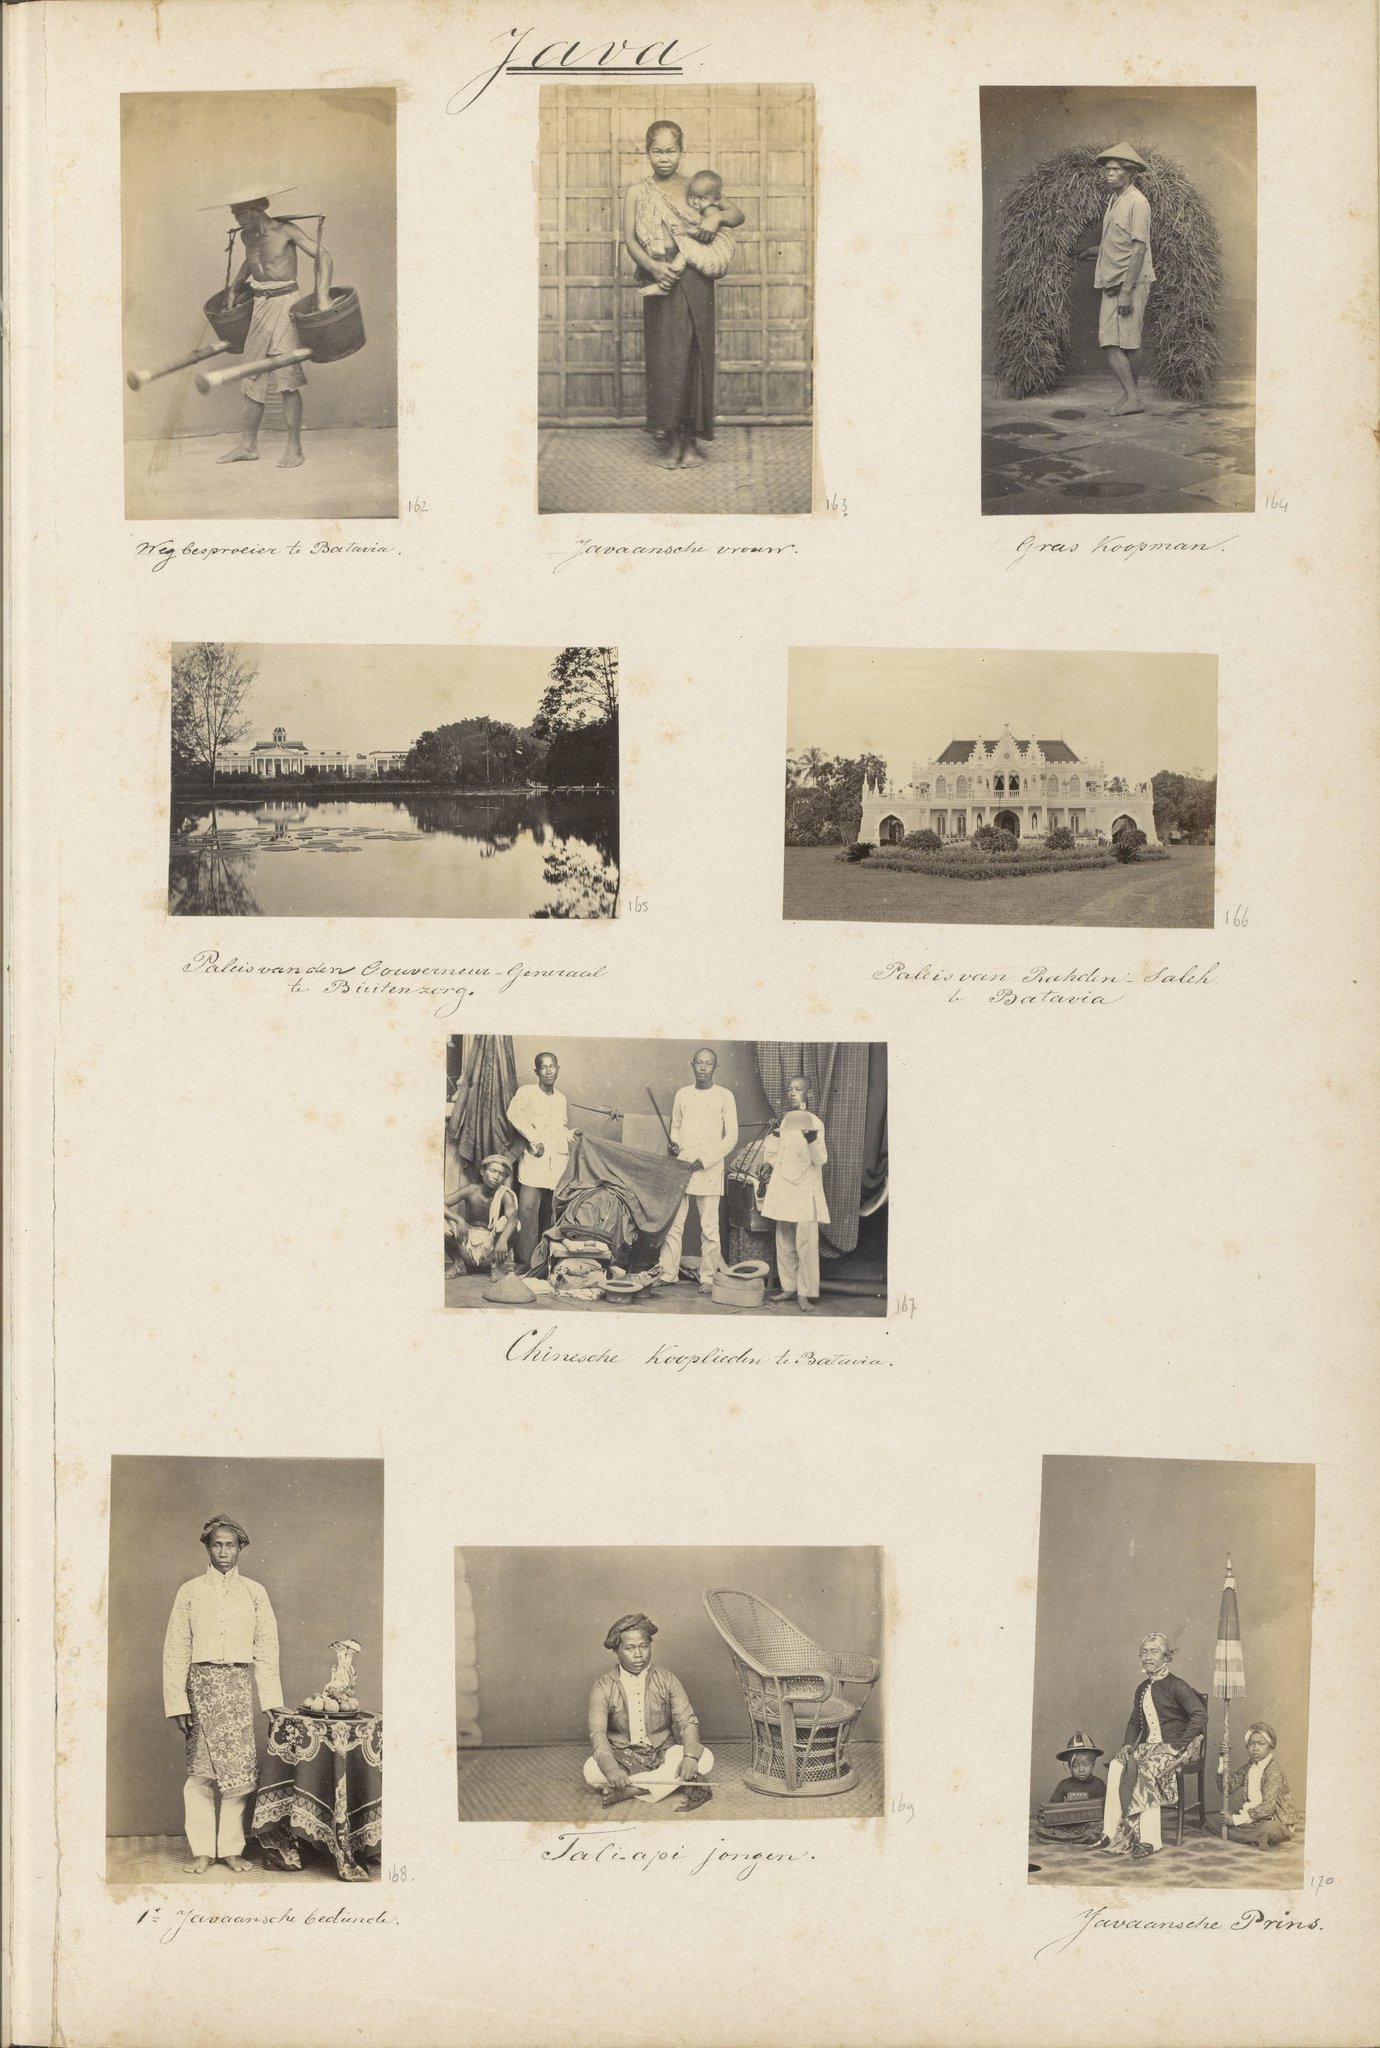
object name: photograph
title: Groepsportret van vier Chinese kooplieden te Batavia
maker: Anonymous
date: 1870-1880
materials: paper, photographic support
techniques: albumen print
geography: batavia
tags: merchant, salesman, batavia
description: Onderdeel van Fotoalbum van Robert Daniel Crommelin (1841-1907).